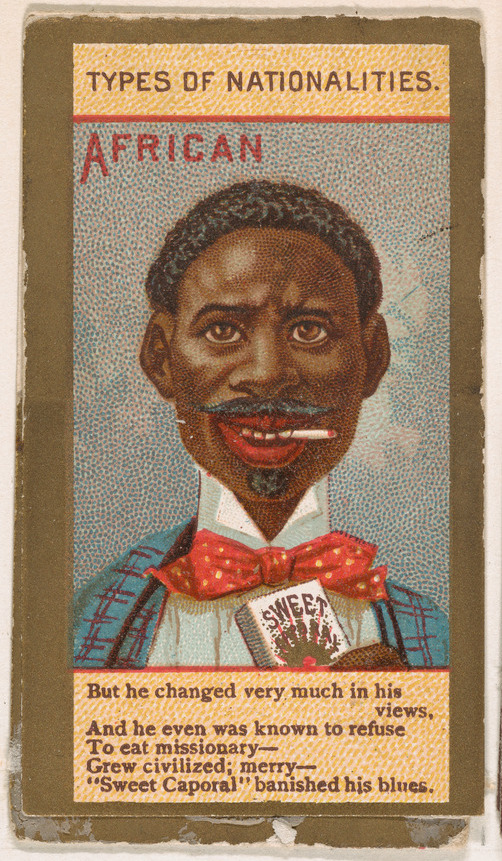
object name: print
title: African, from Types of Nationalities (N240) issued by Kinney Bros.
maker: kinney brothers tobacco company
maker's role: publisher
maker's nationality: american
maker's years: 1869-2011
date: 1890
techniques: color lithograph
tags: men,smoking